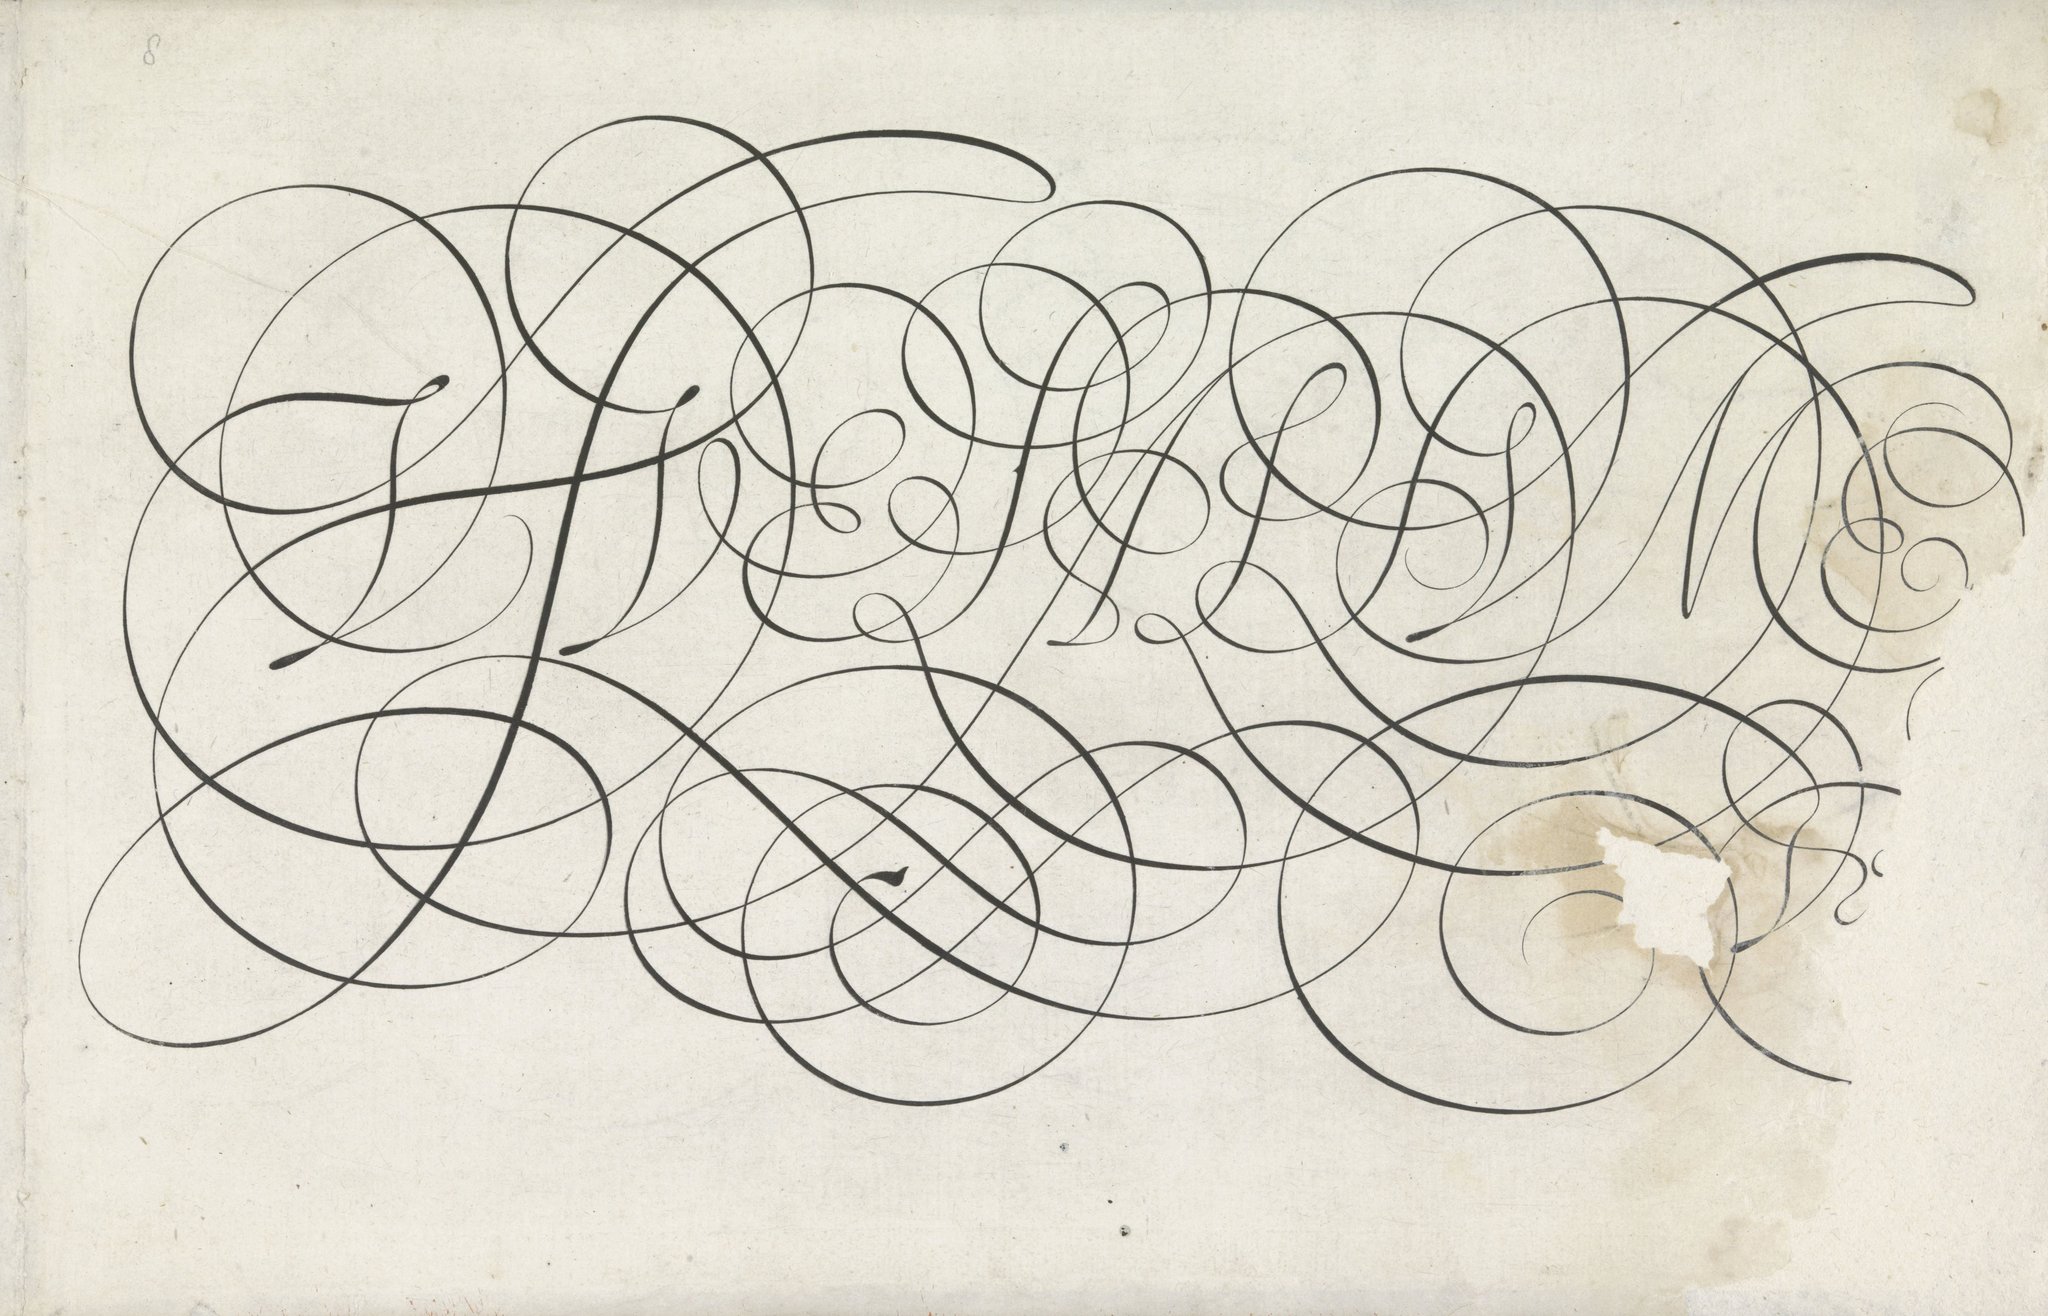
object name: album leaf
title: Schrijfvoorbeeld: Vive la plume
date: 1605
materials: paper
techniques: engraving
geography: haarlem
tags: calligraphy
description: In overdadig gekrulde en doorvlochten Italiaanse kapitaalletter de tekst: Vive la plume. Rechtsonder: Velde. De prent maakt deel uit van een album.